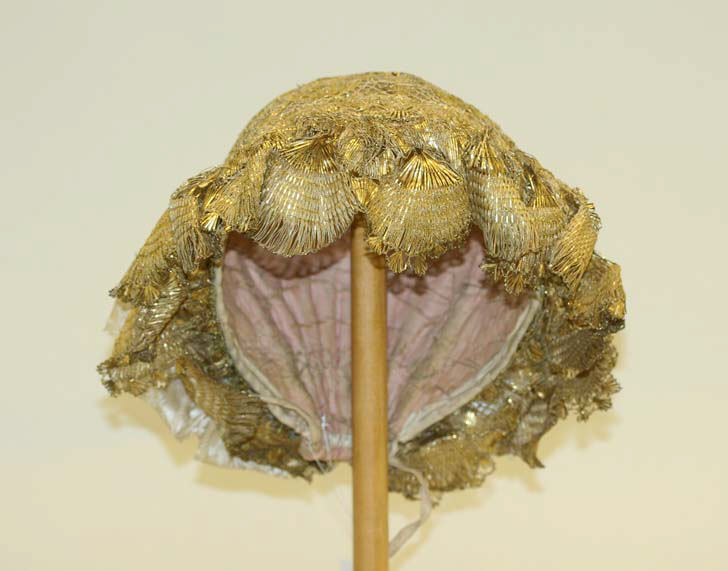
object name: headdress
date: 1801-1900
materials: cotton, metal thread